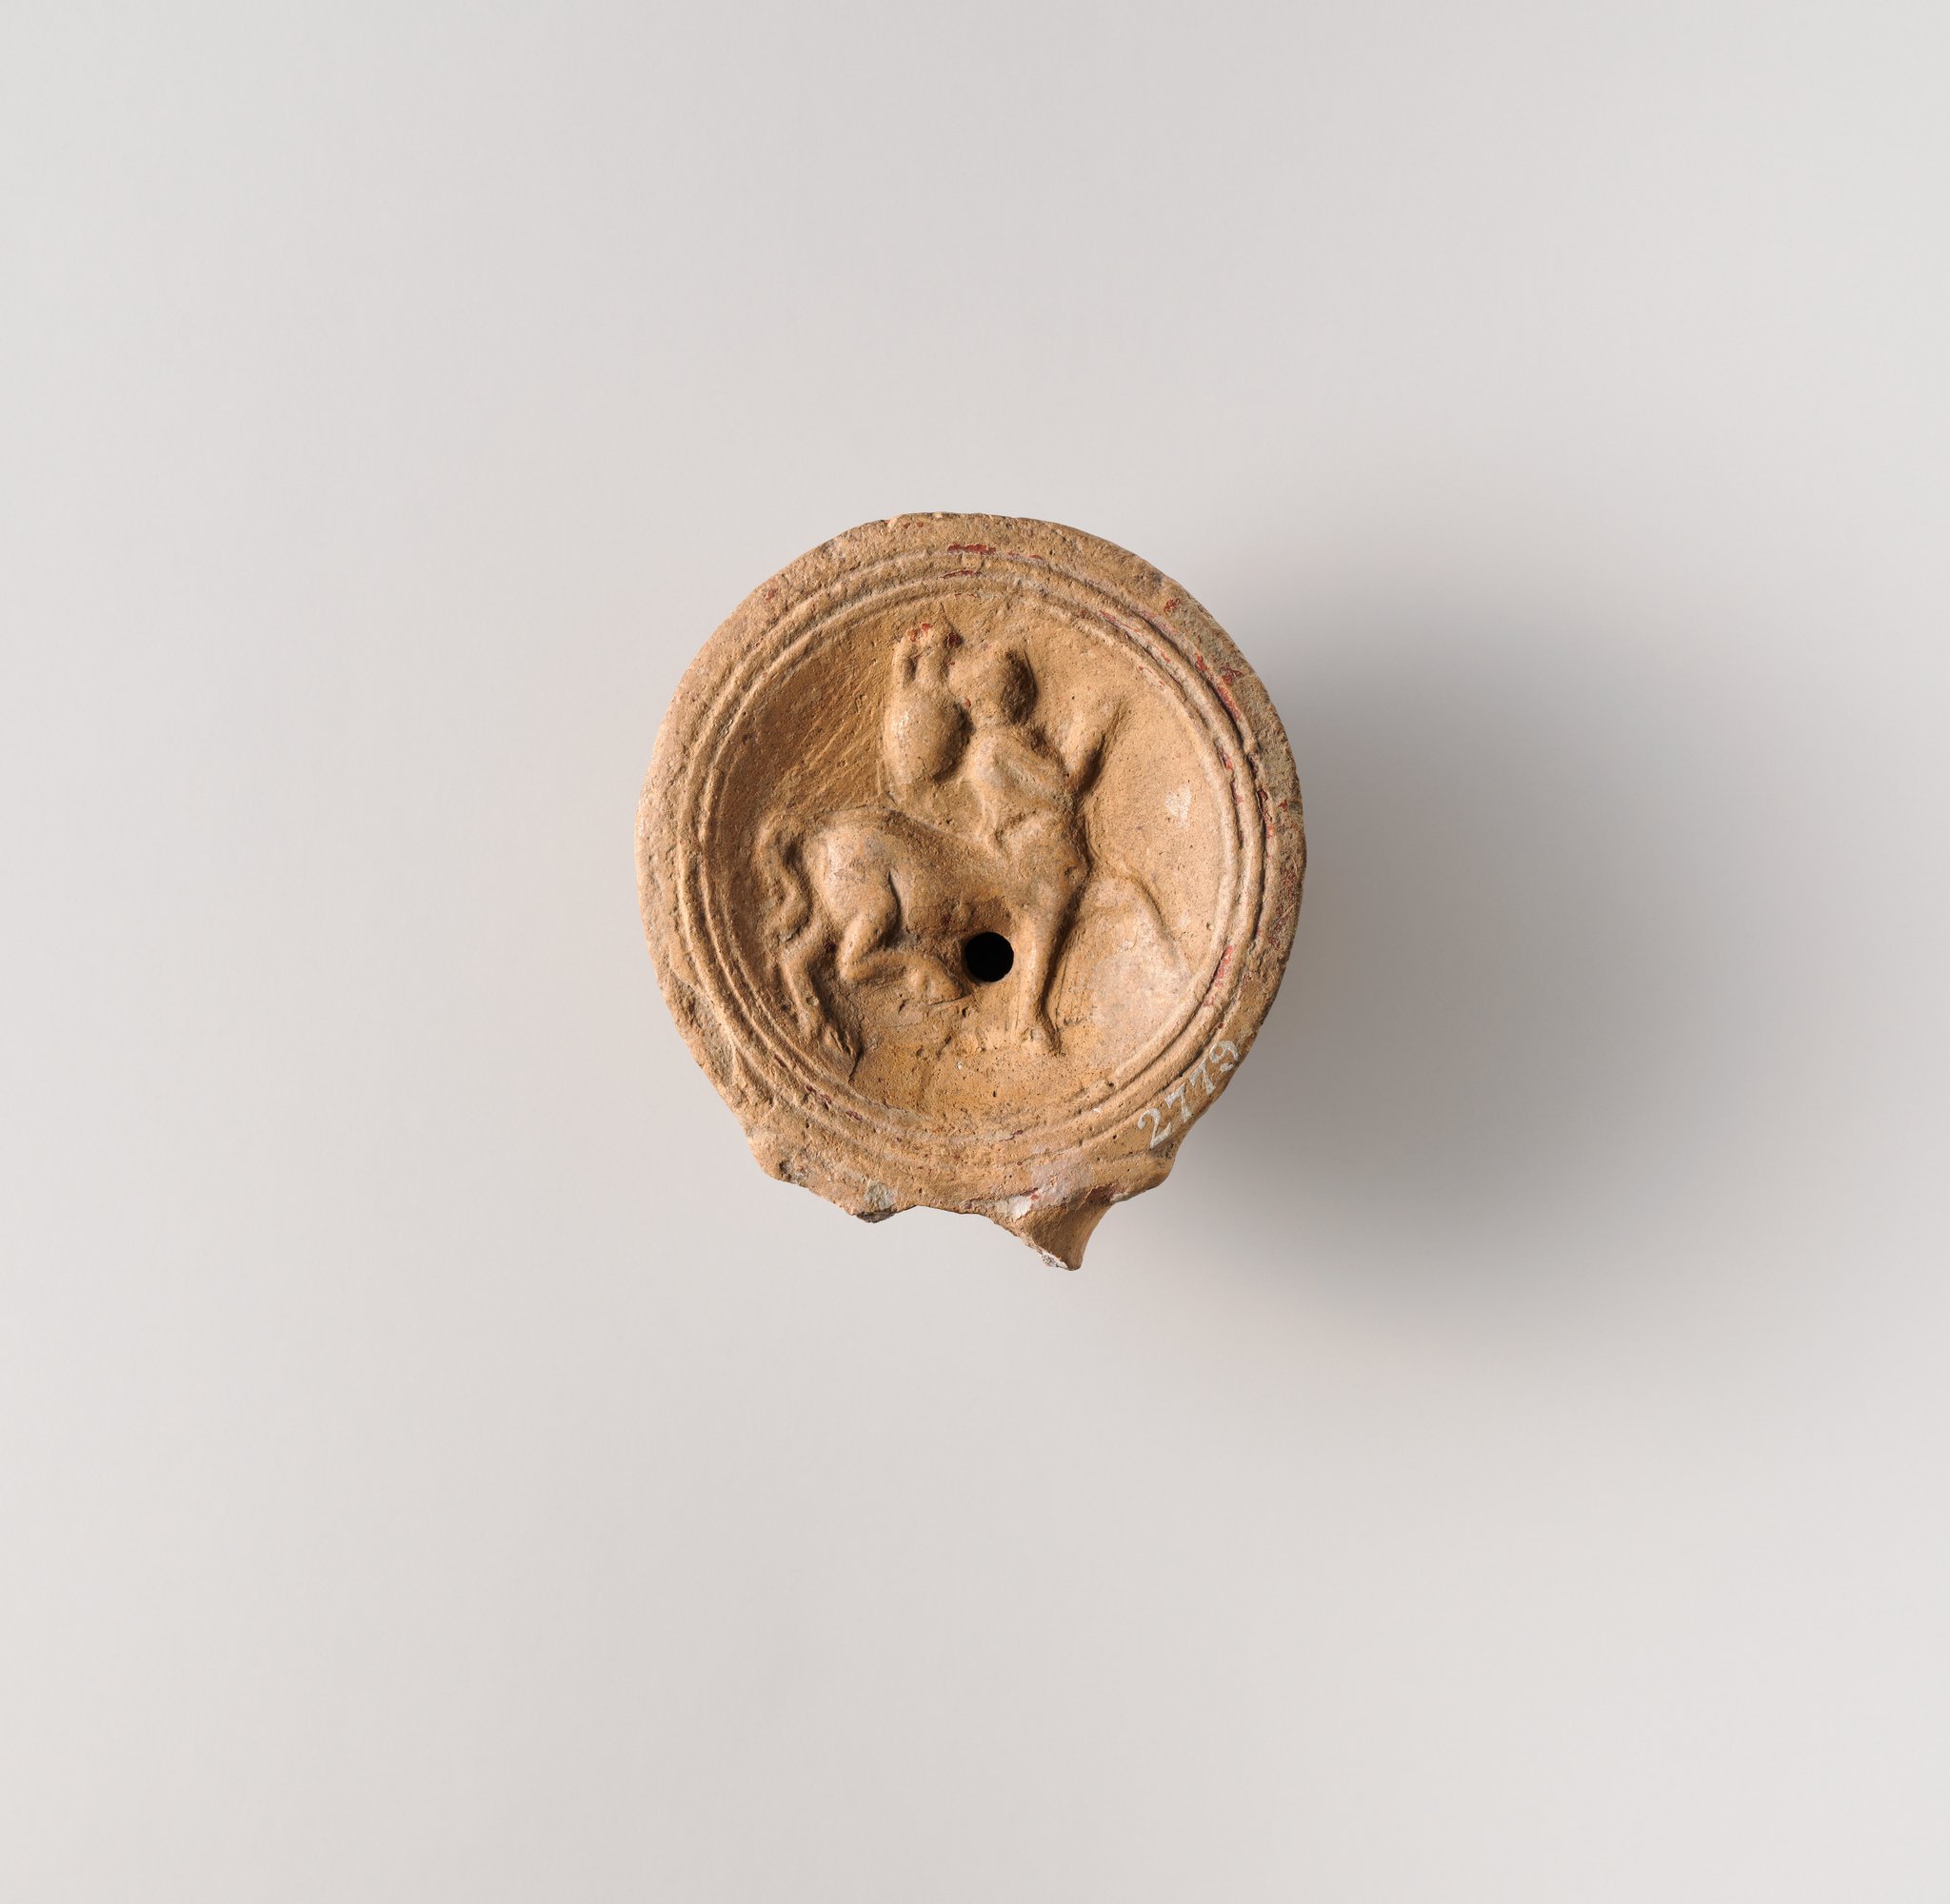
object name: lamp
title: Terracotta oil lamp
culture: roman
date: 1-100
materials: terracotta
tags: centaurs